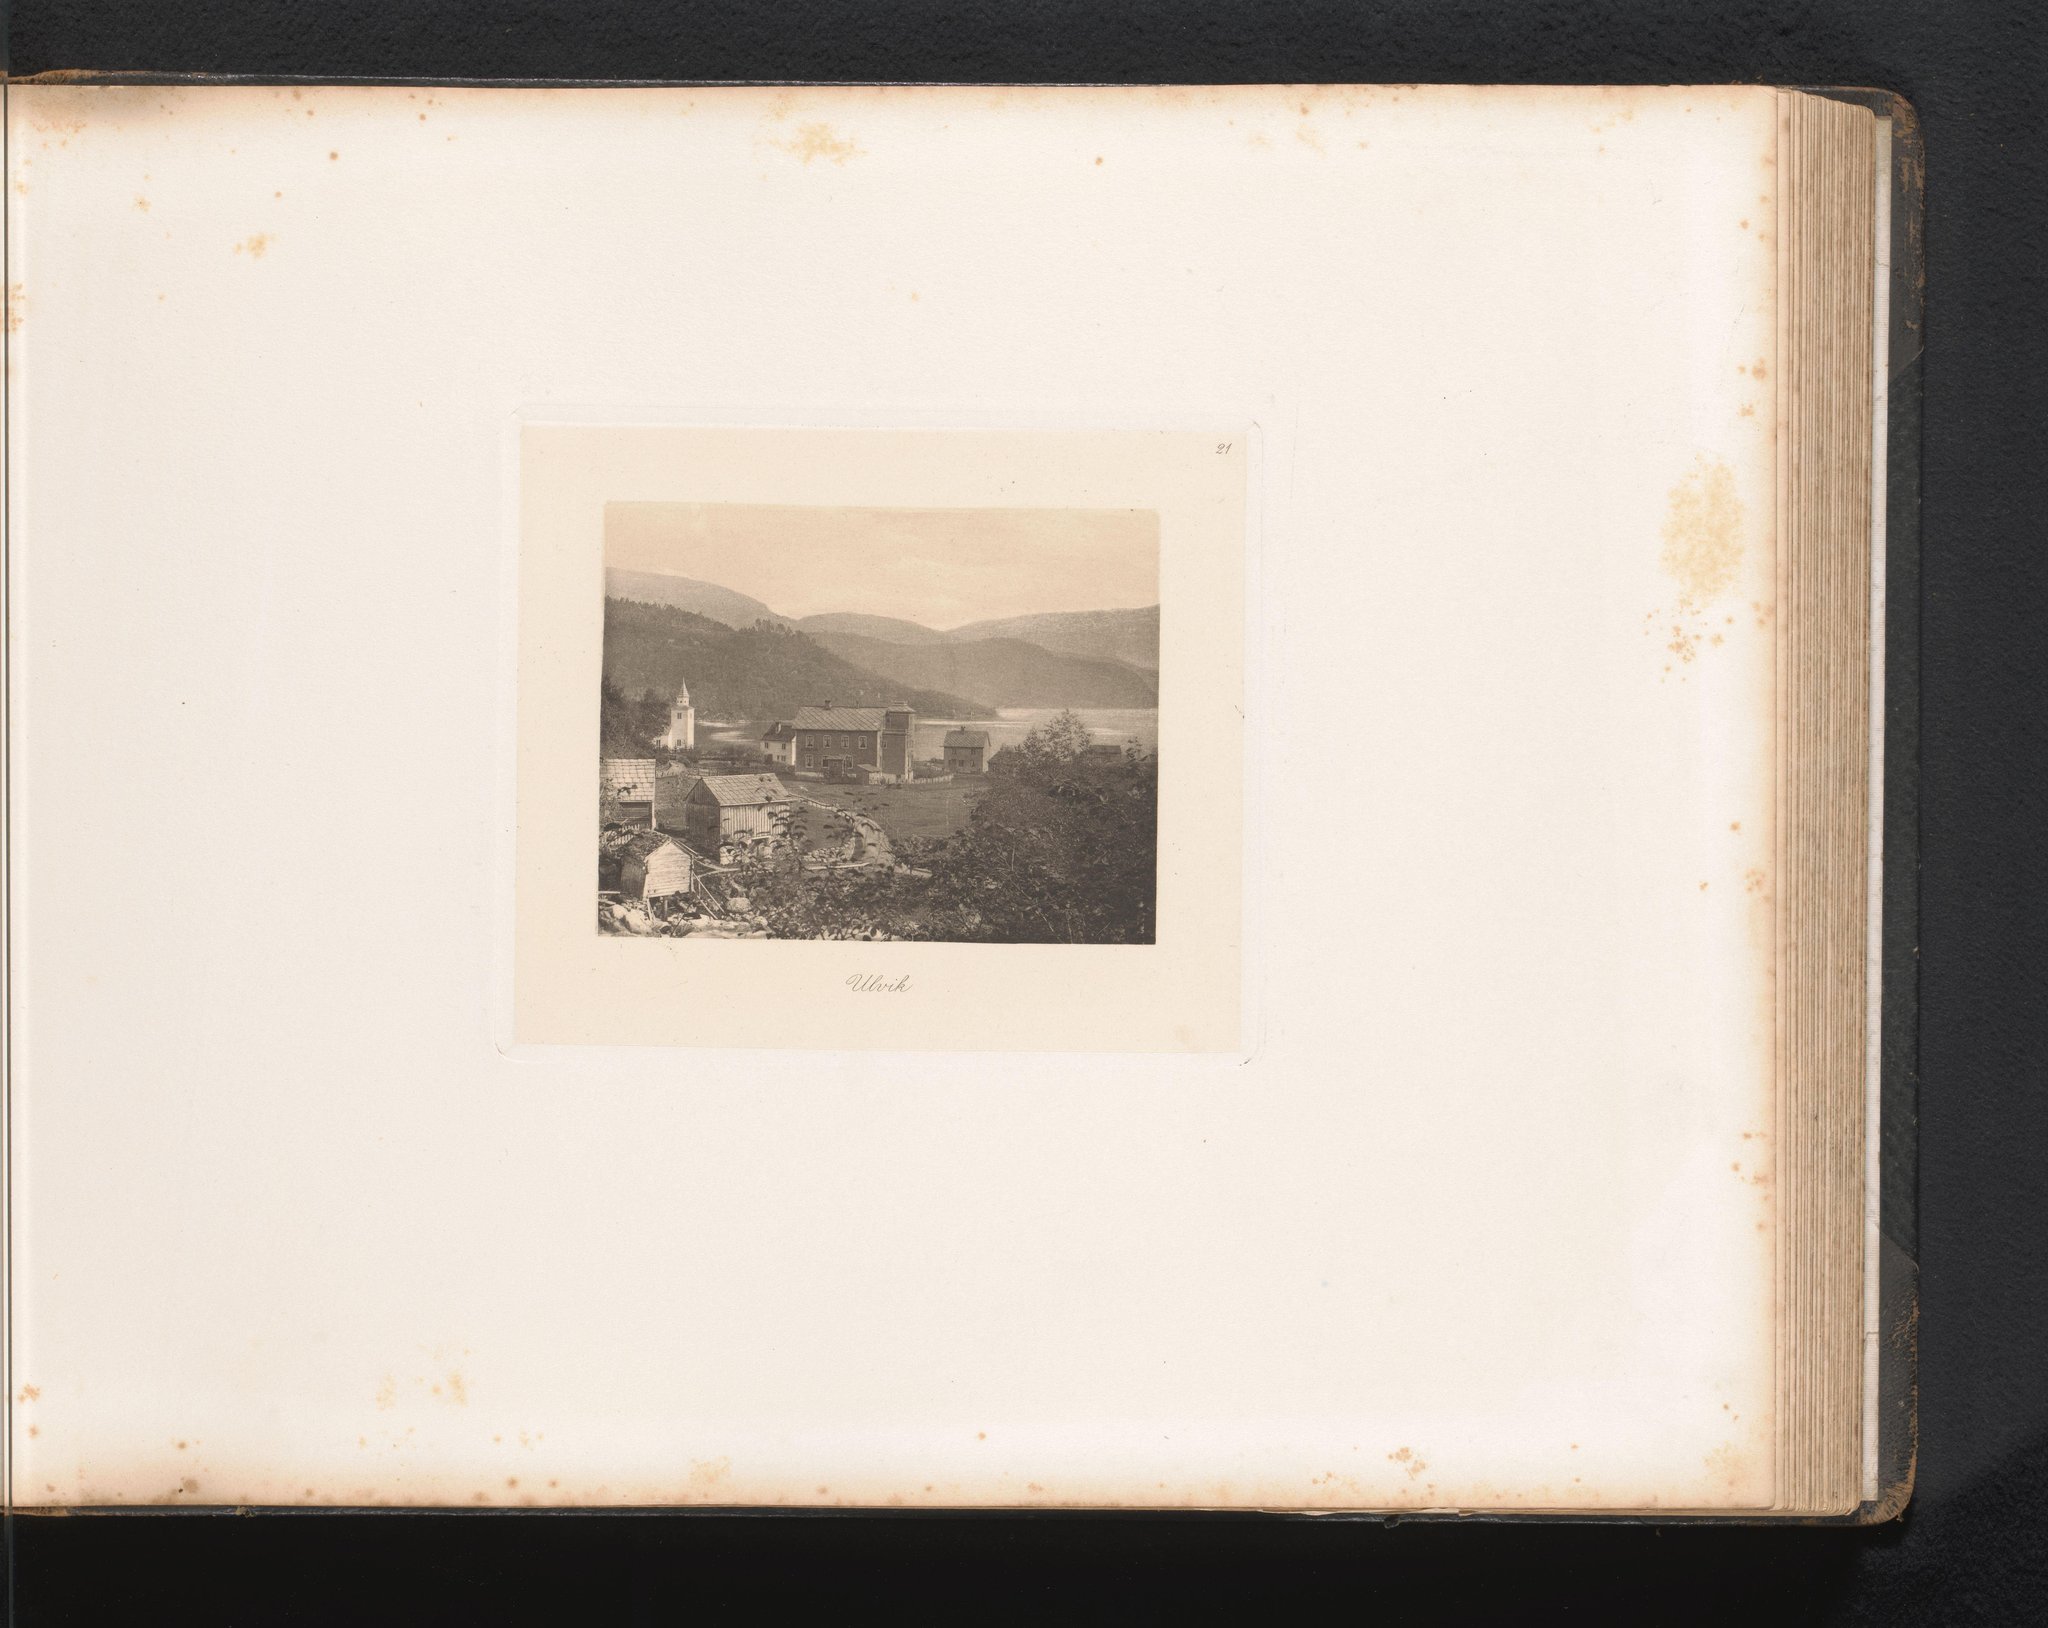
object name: photomechanical print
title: Ulvik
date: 1888-1893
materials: paper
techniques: photograph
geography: vienna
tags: city-view in general; 'veduta'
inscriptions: number: ‘21’